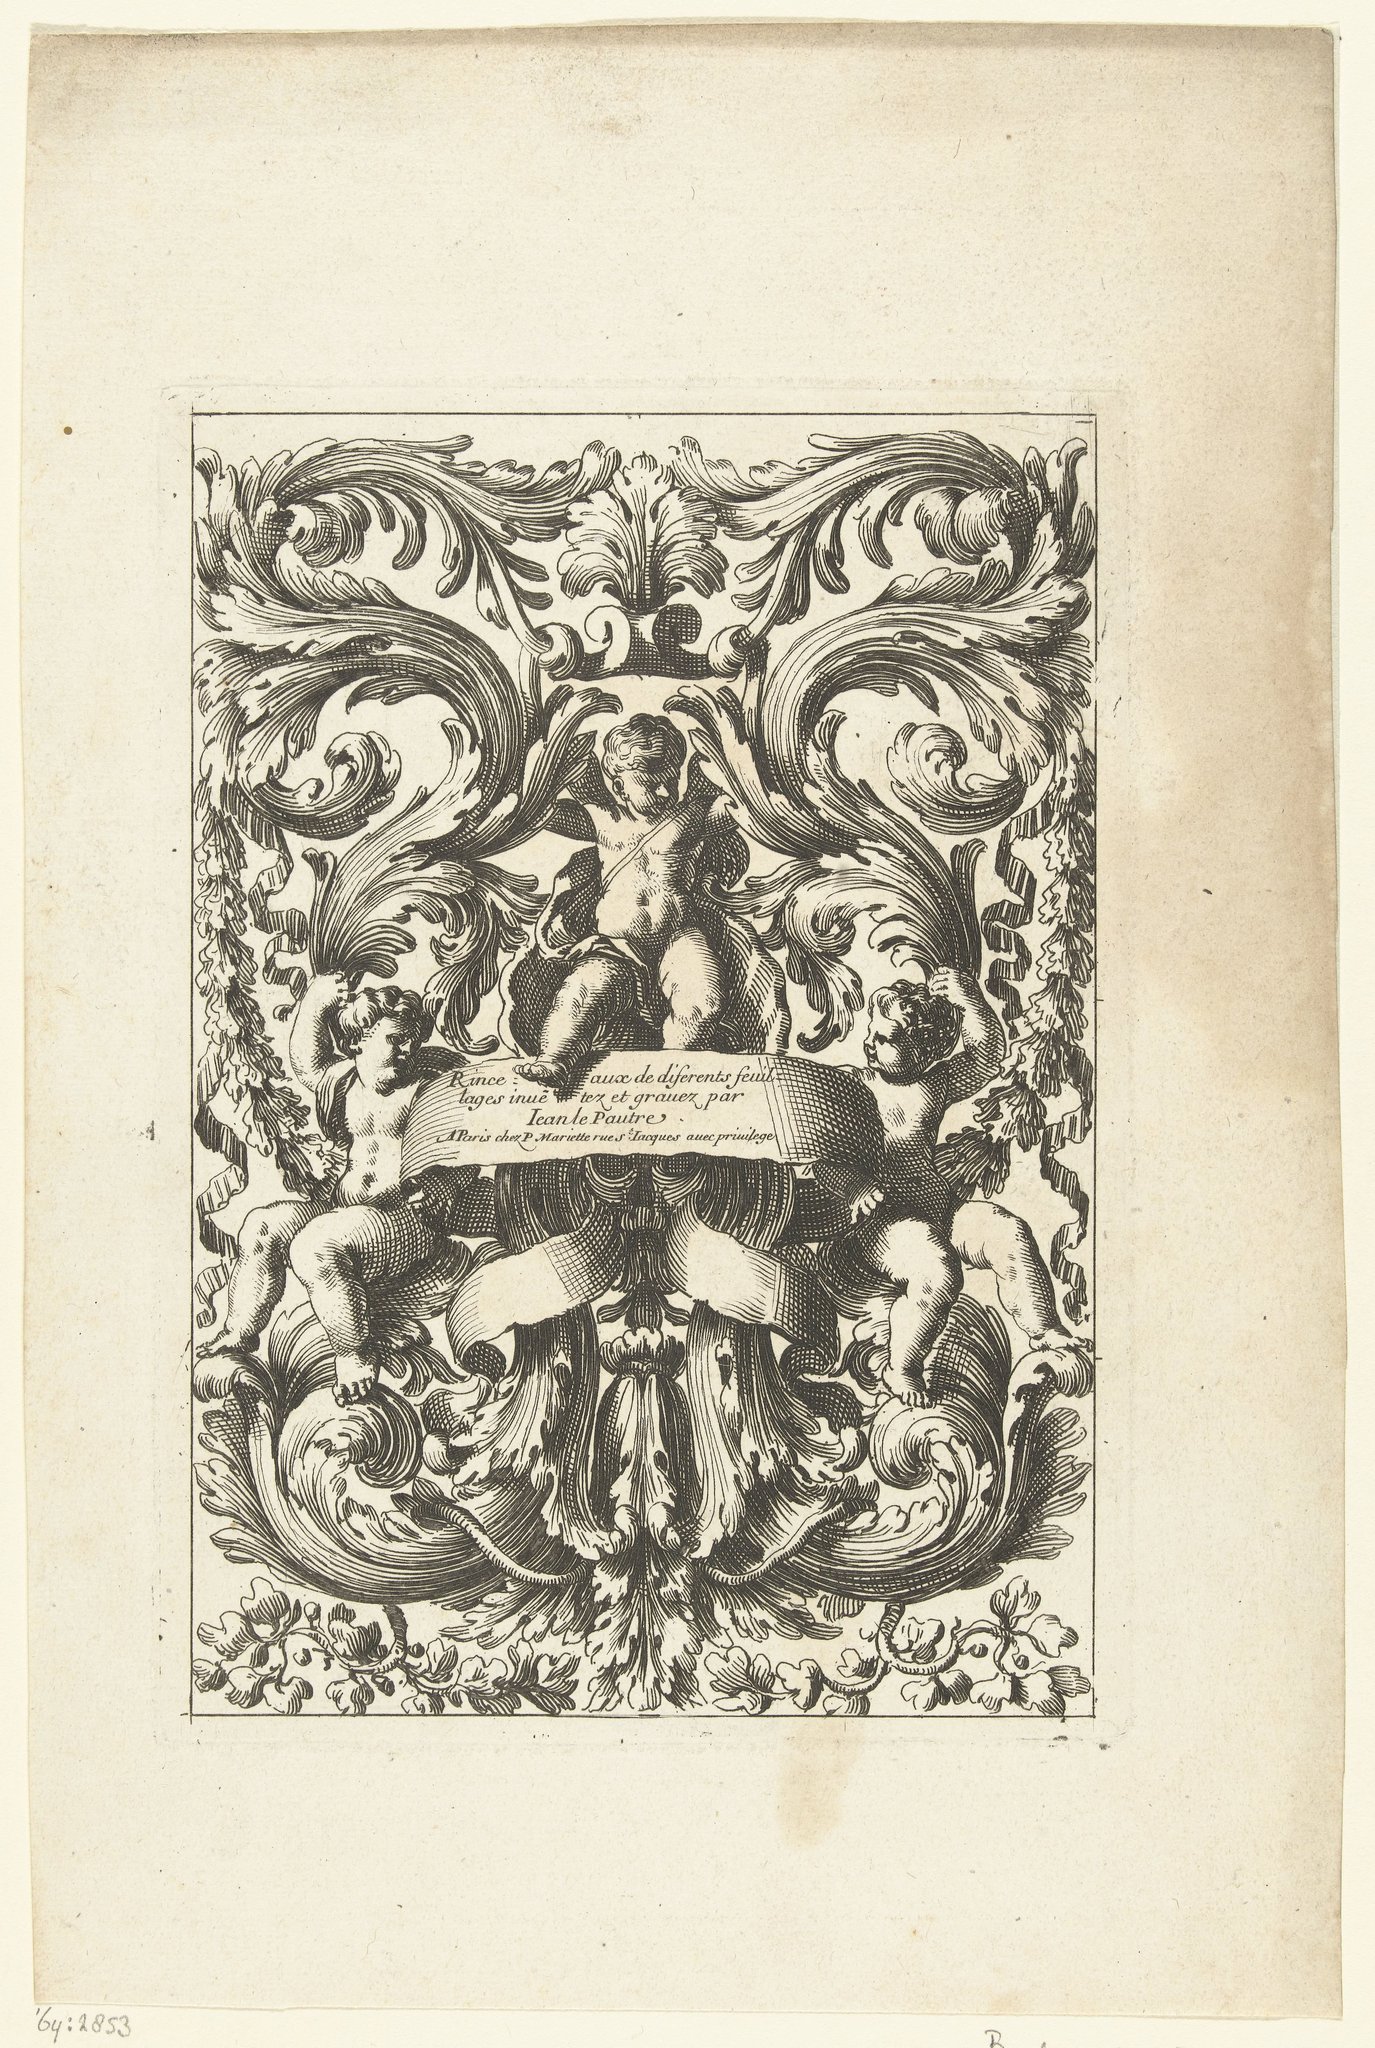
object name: print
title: Rinceaux de diferents feuillages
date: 1657-1667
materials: paper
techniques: etching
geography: france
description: Symmetrische, verticale bladranken, in het midden omwonden met een banderol waarop de titel staat. Titelblad uit serie van 6.